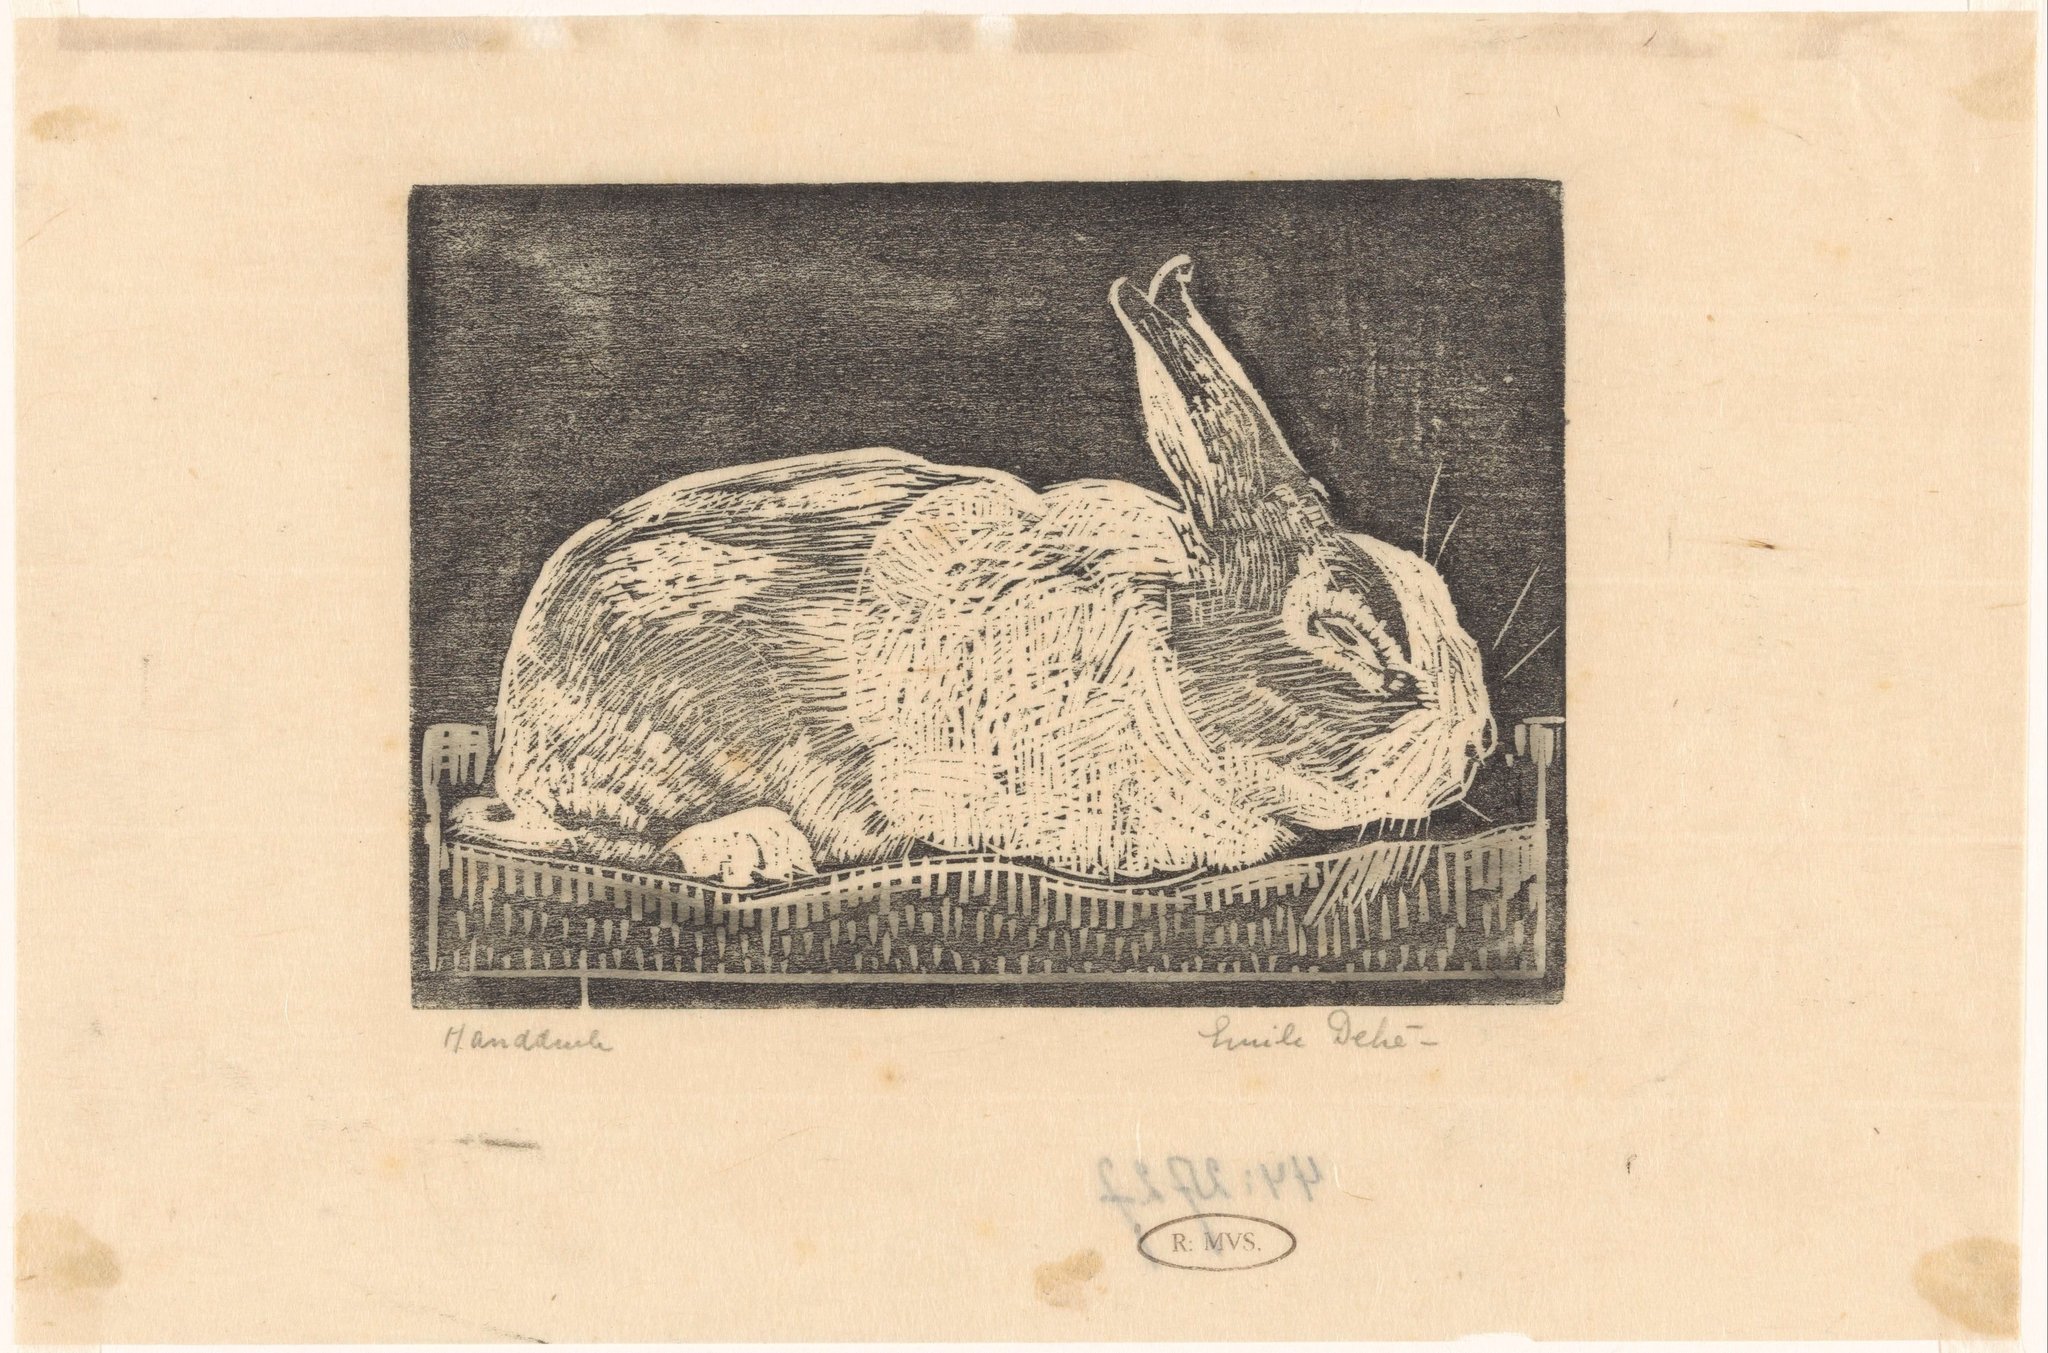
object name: print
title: Konijn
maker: emilius wilhelmus dehé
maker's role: draughtsman, print maker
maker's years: 1886-1947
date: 1896-1944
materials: paper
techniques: woodcut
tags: rodents: rabbit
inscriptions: collector's mark: Lugt 2228